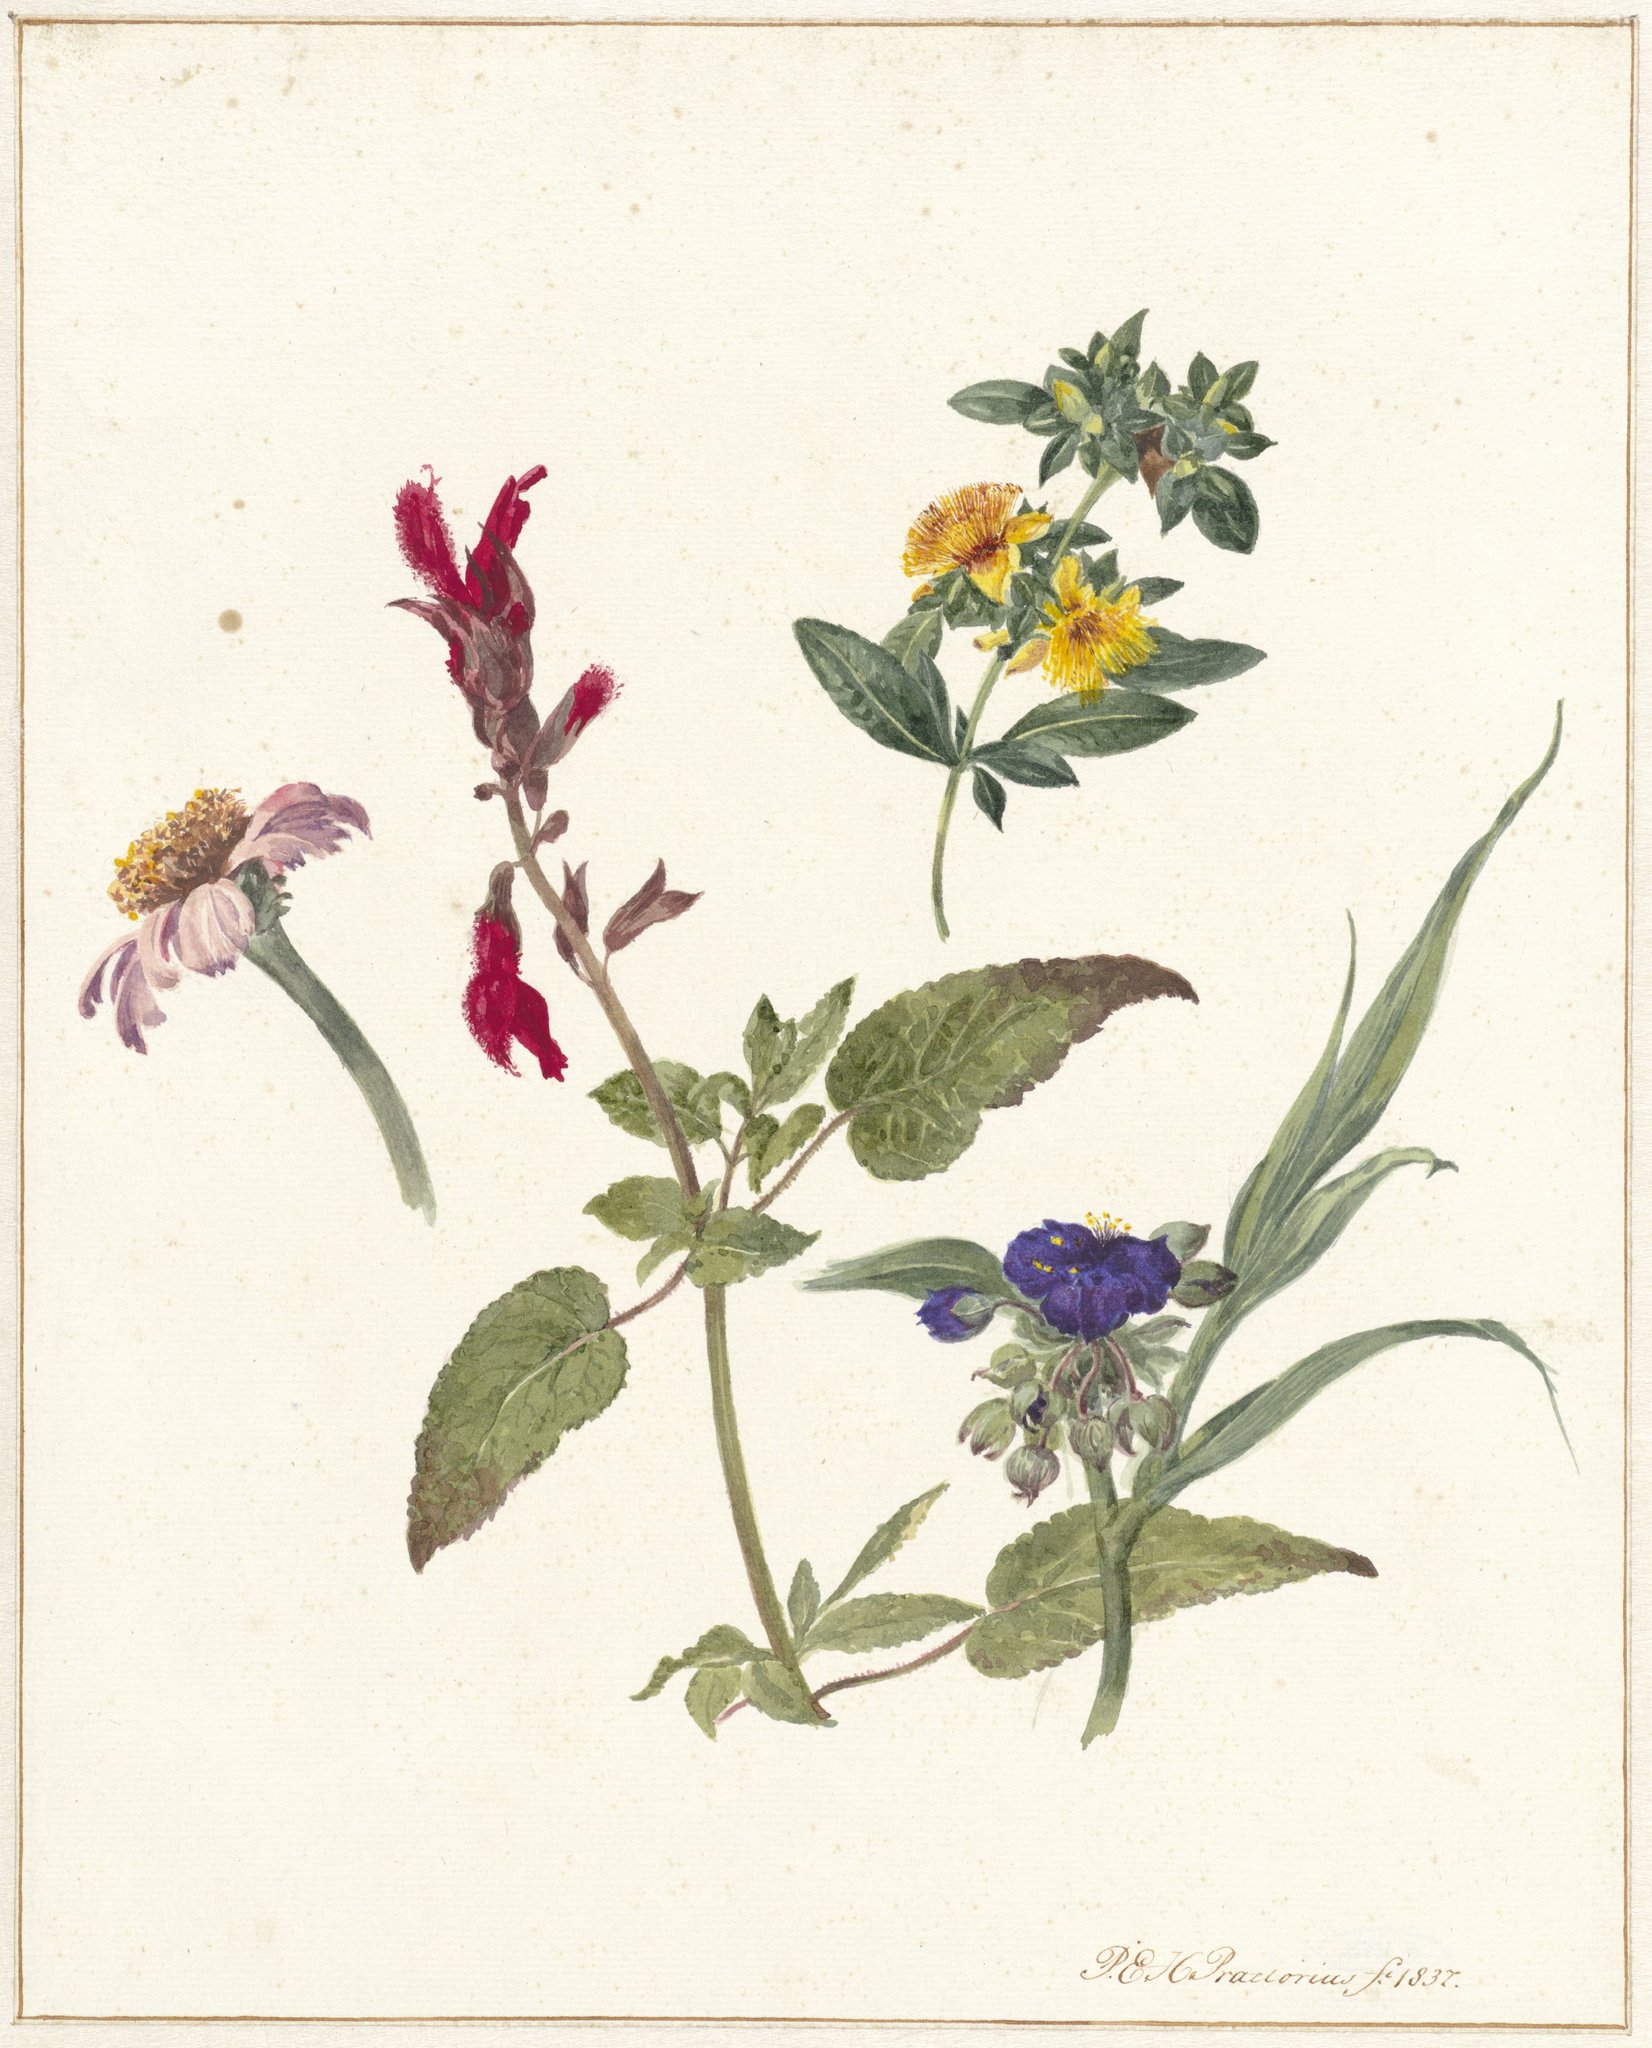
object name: drawing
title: Studies van veldbloemen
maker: pieter ernst hendrik praetorius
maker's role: draughtsman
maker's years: 1791-1876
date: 1837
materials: paper, watercolor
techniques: brush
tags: flowers